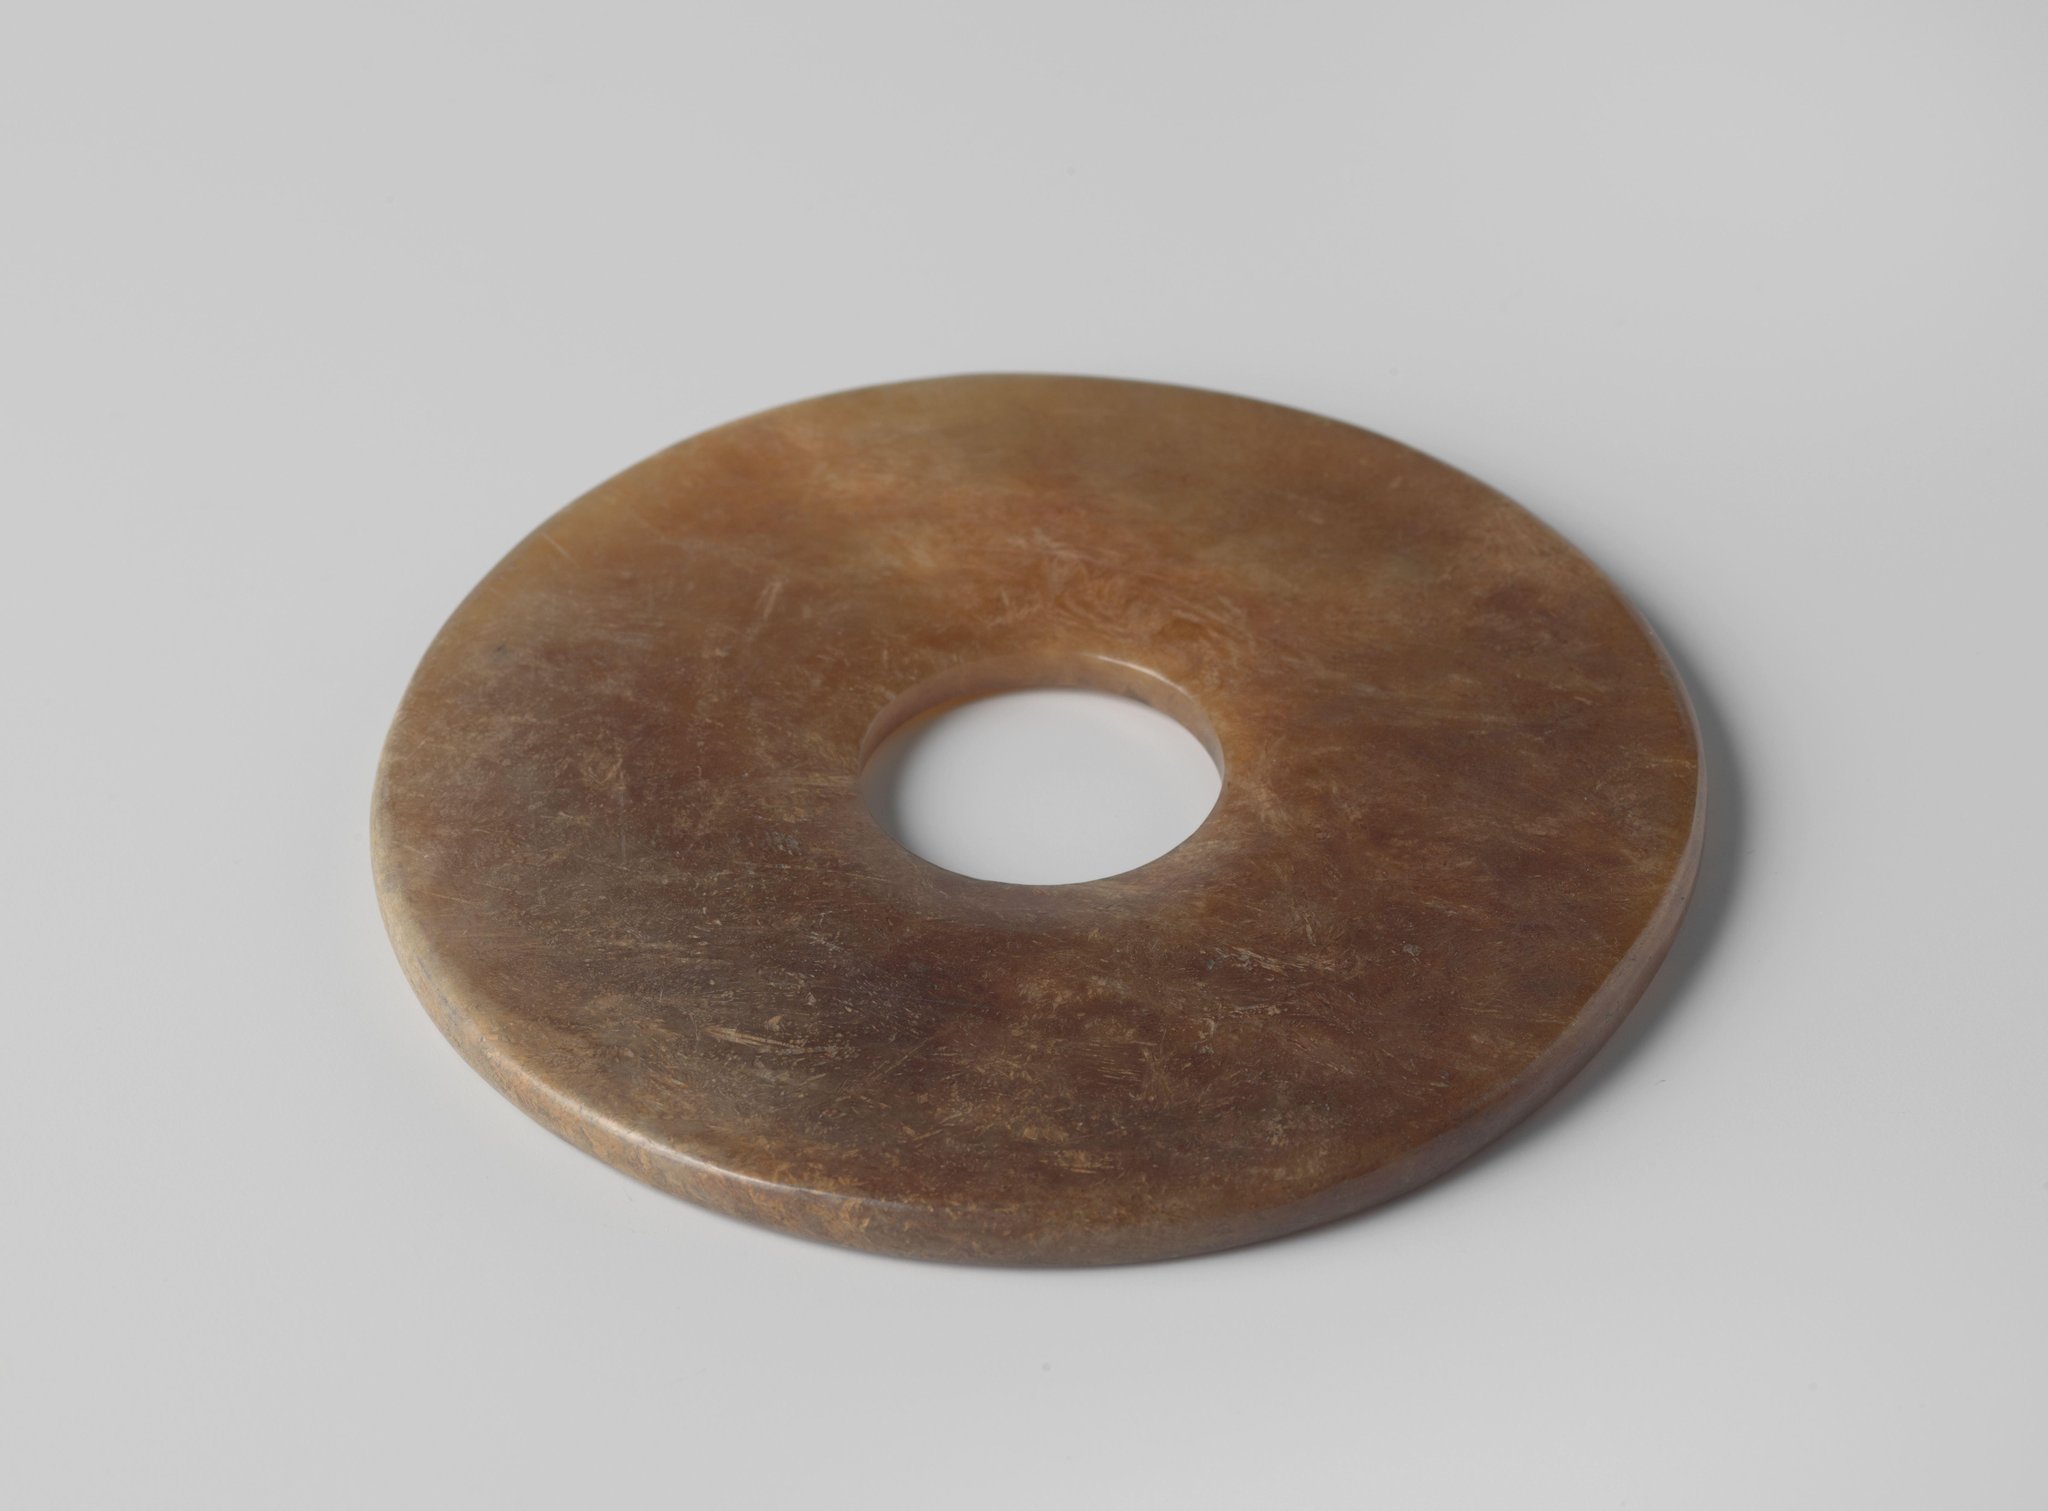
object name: bi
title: Bi; schijf van bruine jade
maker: Anonymous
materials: jade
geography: china